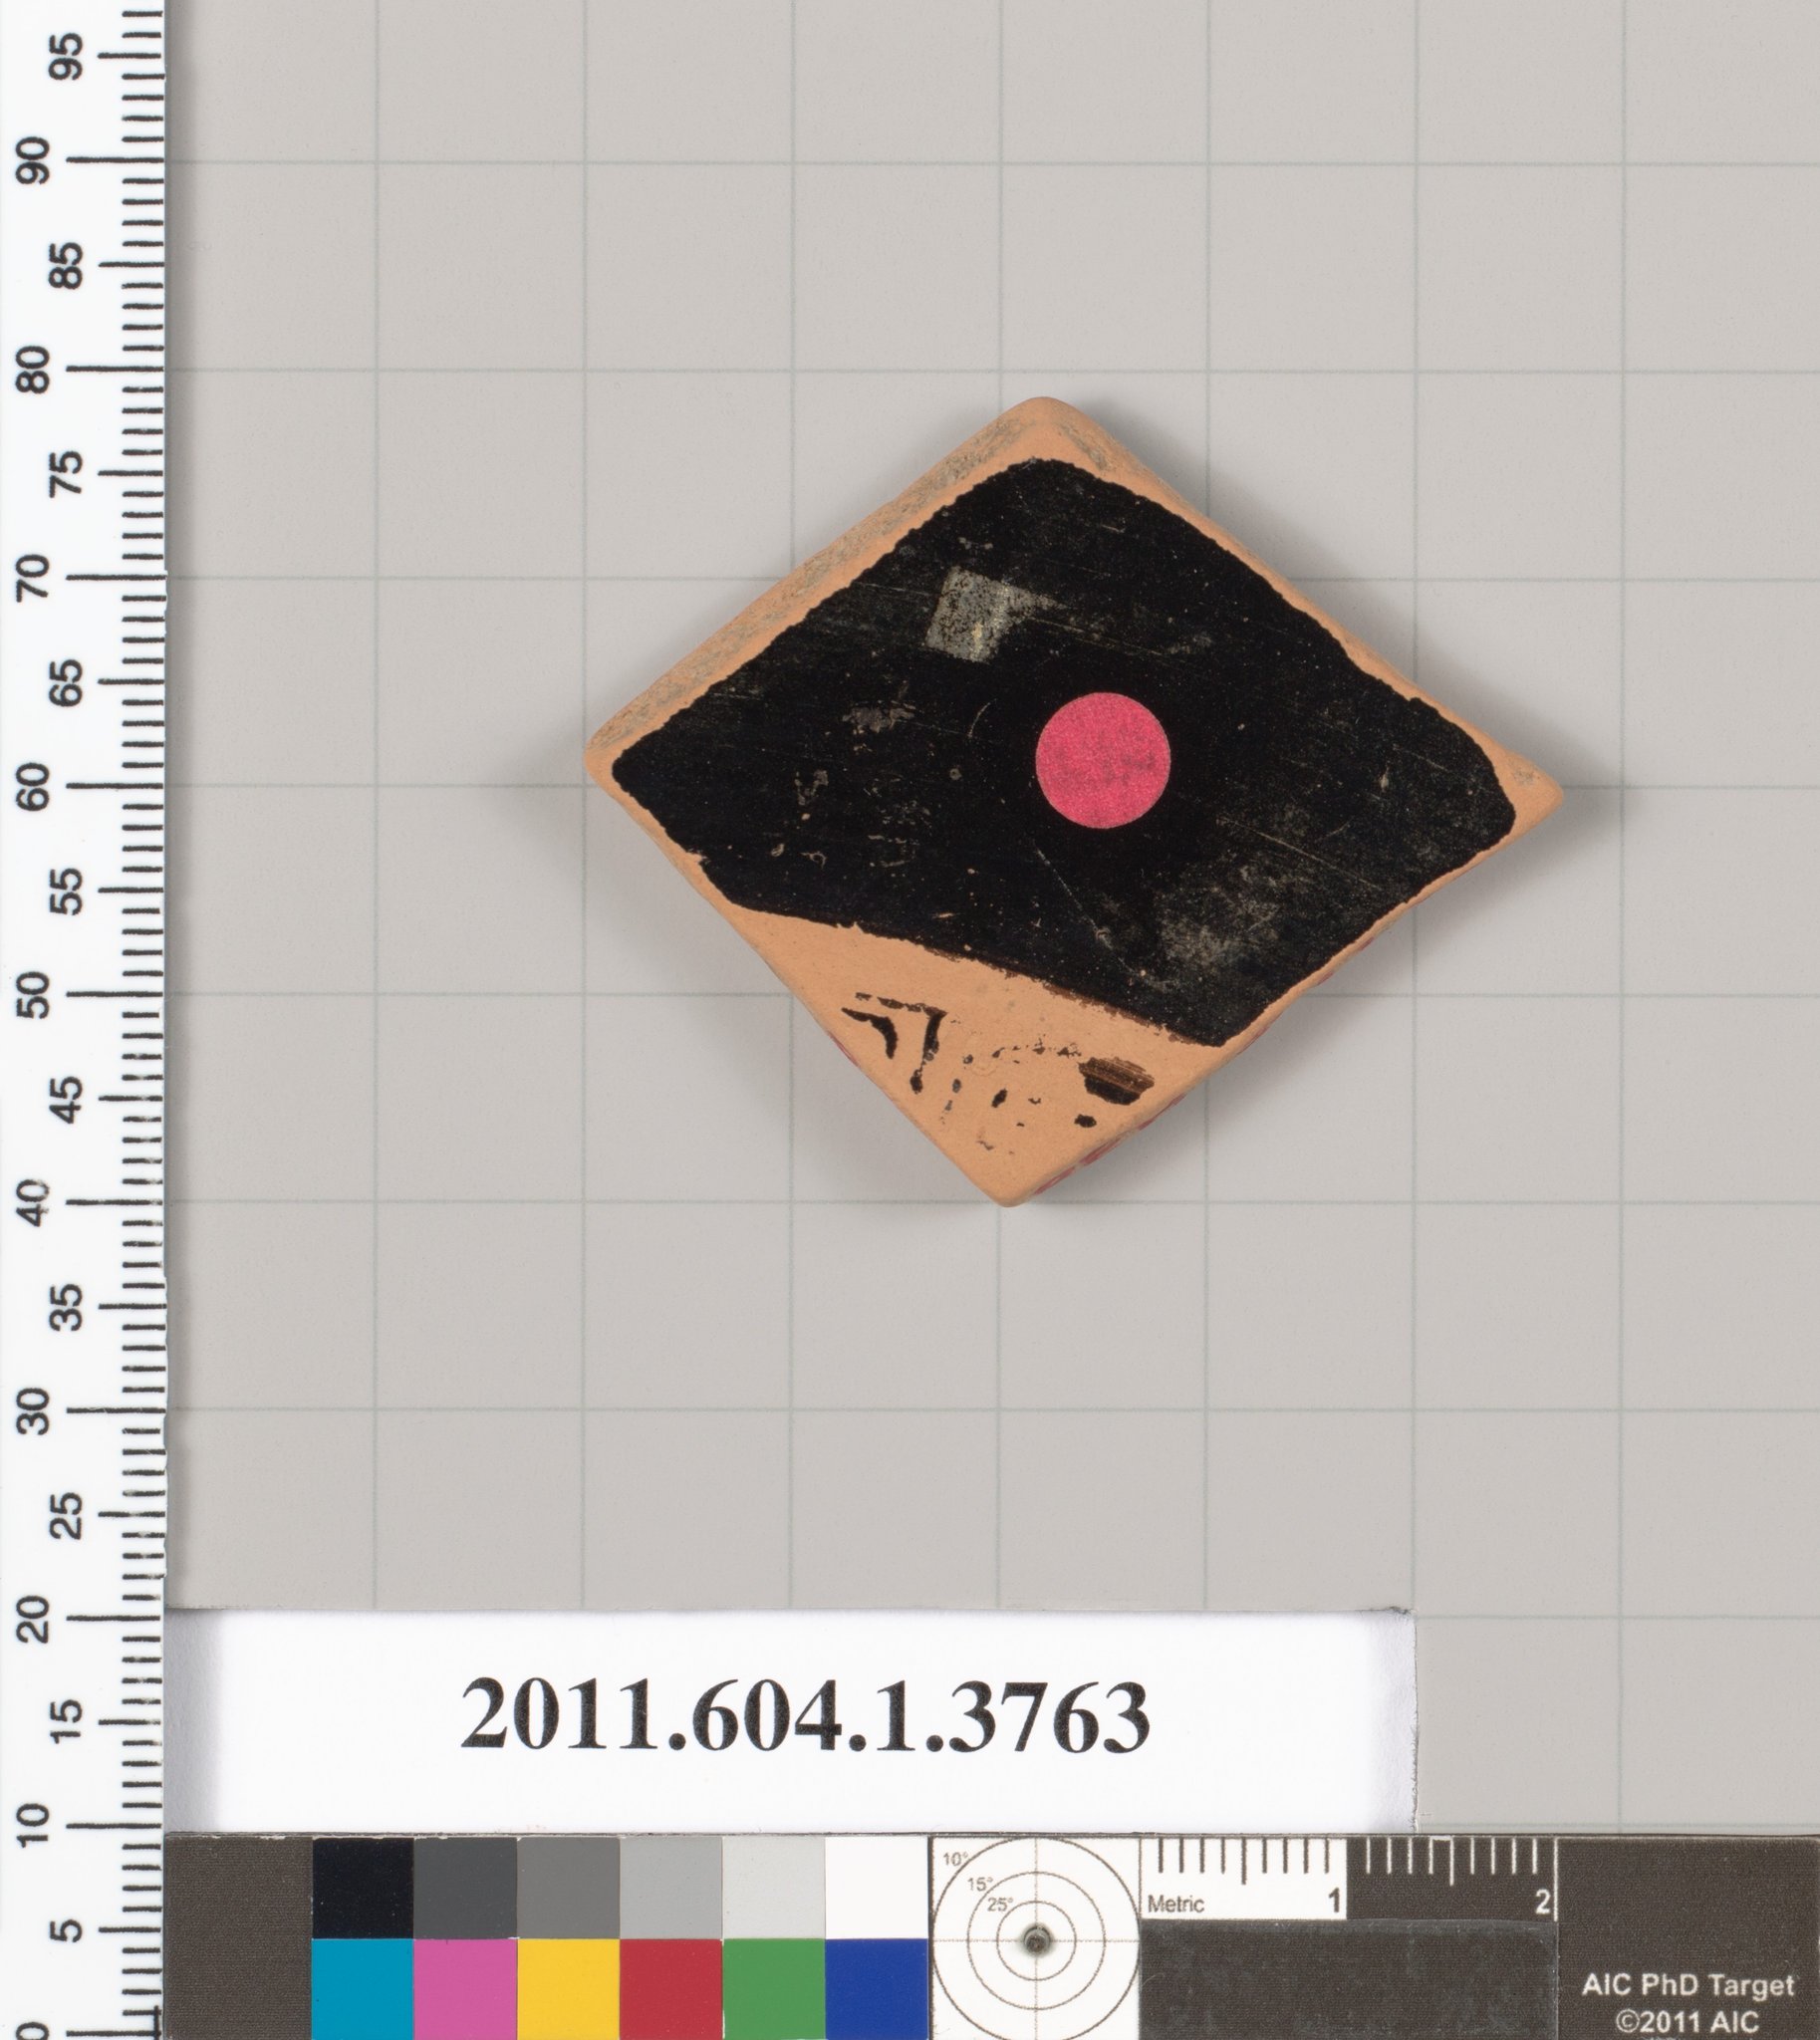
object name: kylix fragment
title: Terracotta fragment of a kylix (drinking cup)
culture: greek, attic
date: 460-450 BCE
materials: terracotta